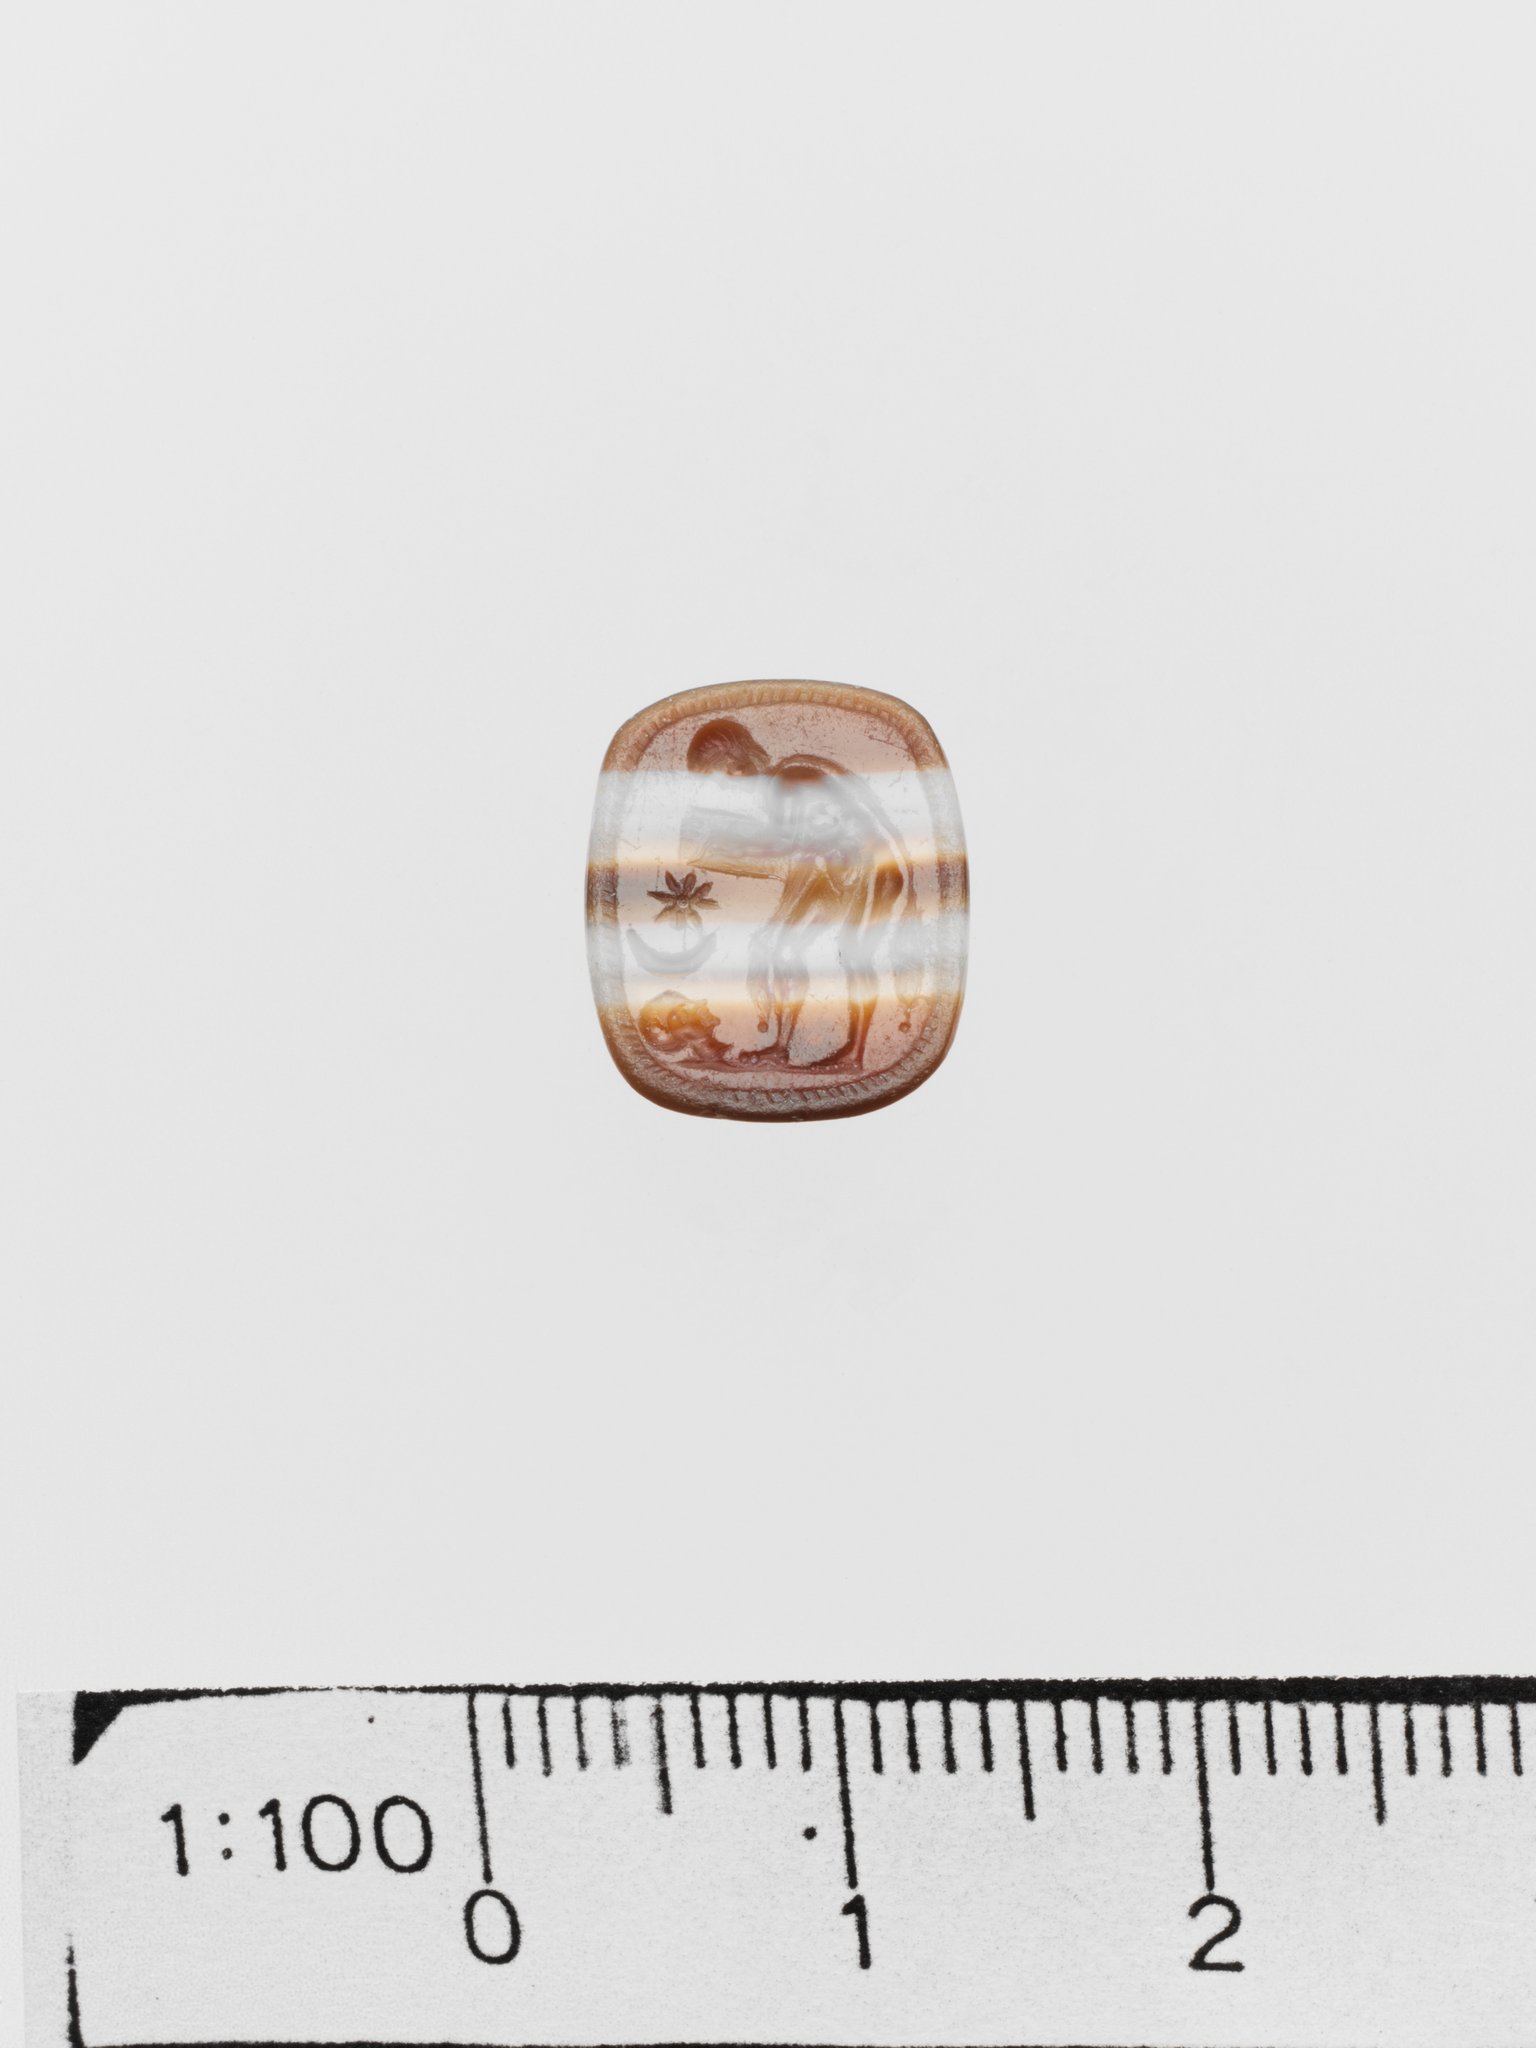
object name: intaglio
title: Banded agate ring stone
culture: italic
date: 300-101 BCE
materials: stone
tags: tablets,heads,men,writing